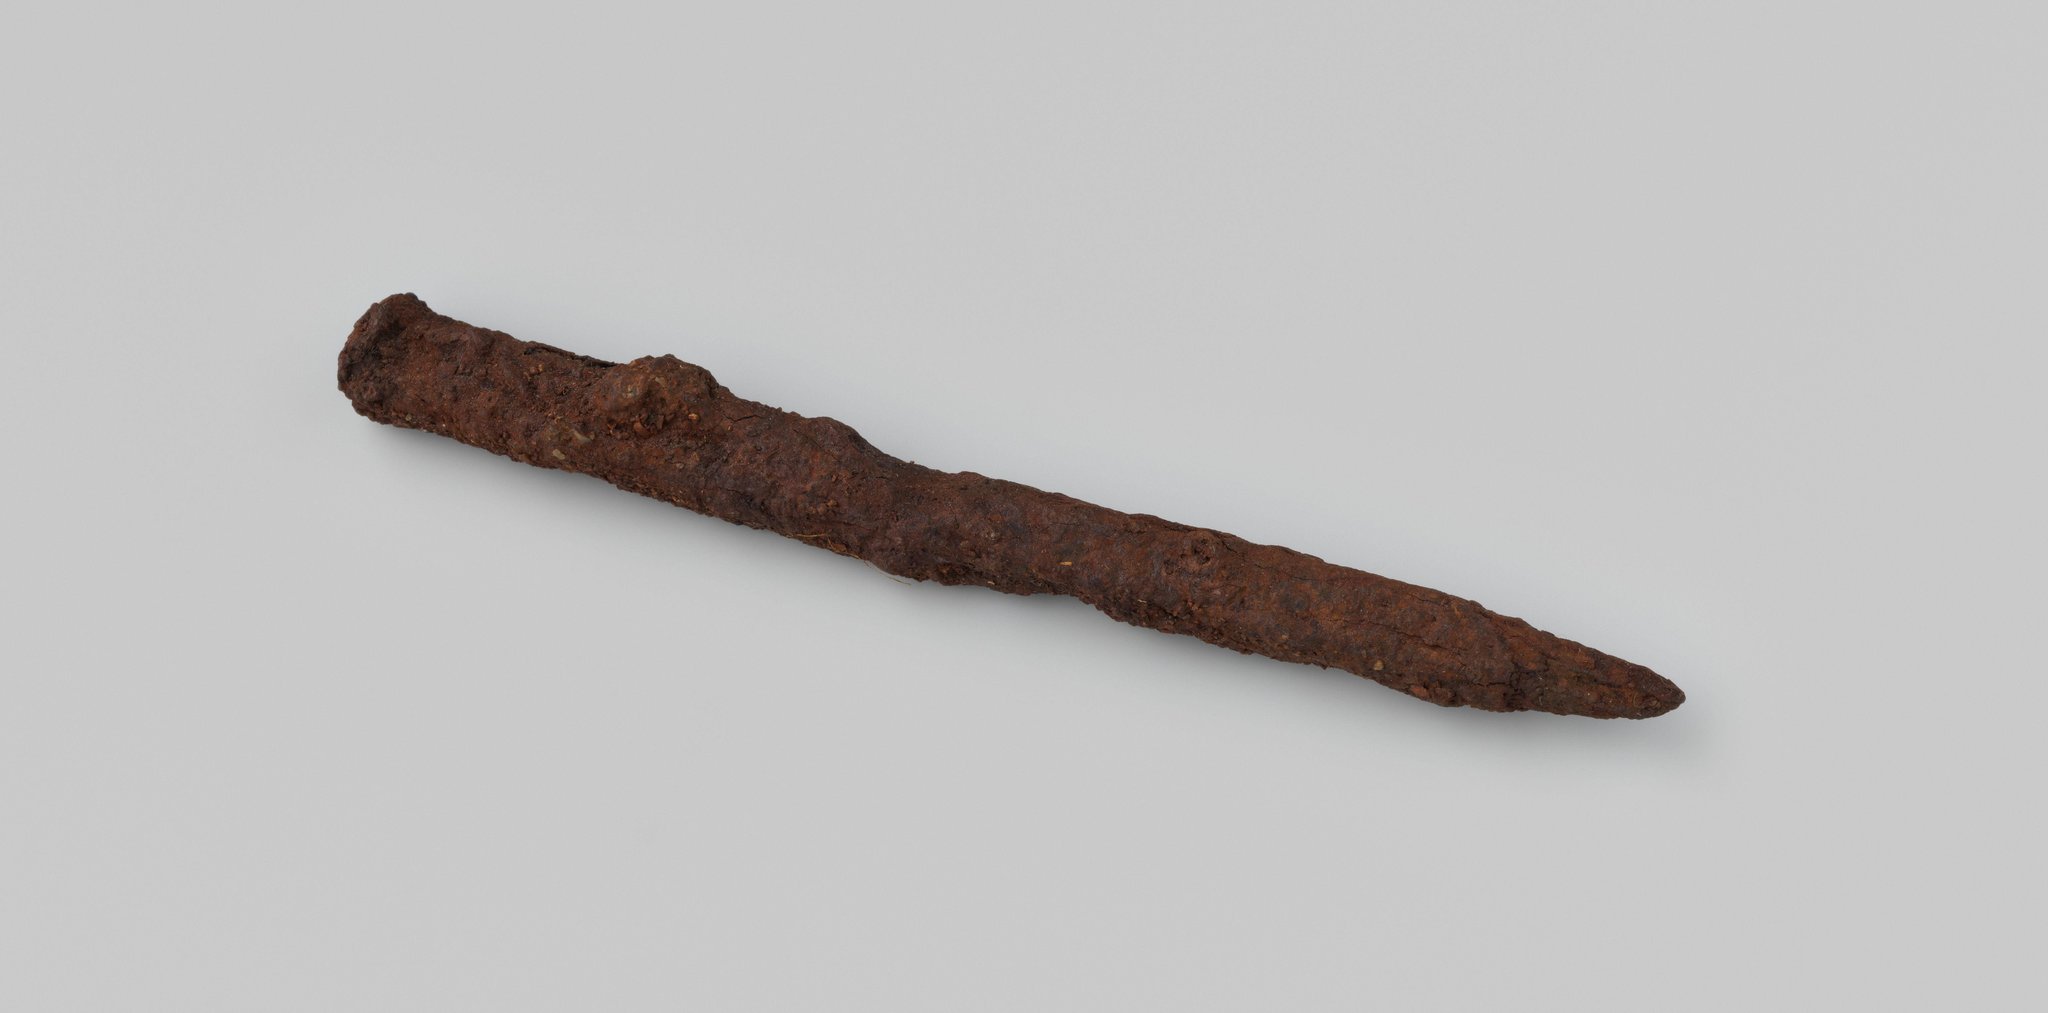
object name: nagel, spijker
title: Spijker afkomstig uit het wrak van de Oost-Indiëvaarder Hollandia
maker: Anonymous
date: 1700-1743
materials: iron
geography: netherlands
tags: verenigde oostindische compagnie, hollandia (schip)